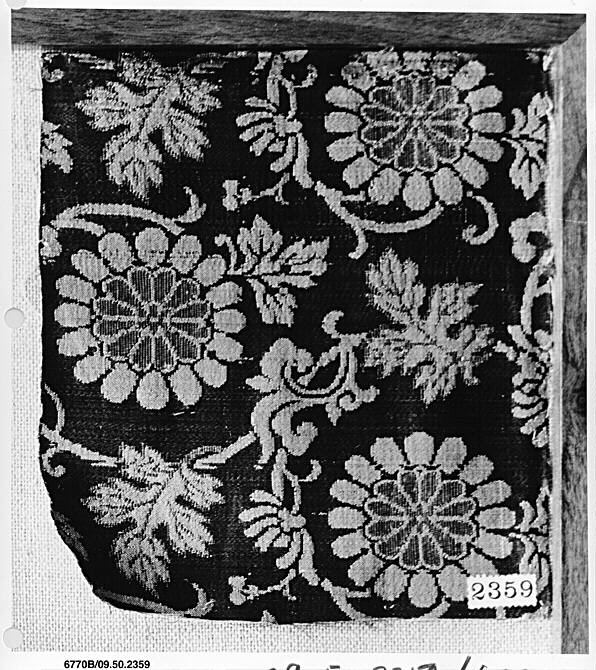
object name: piece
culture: japanese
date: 1801-1900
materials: metal thread, silk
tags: leaves